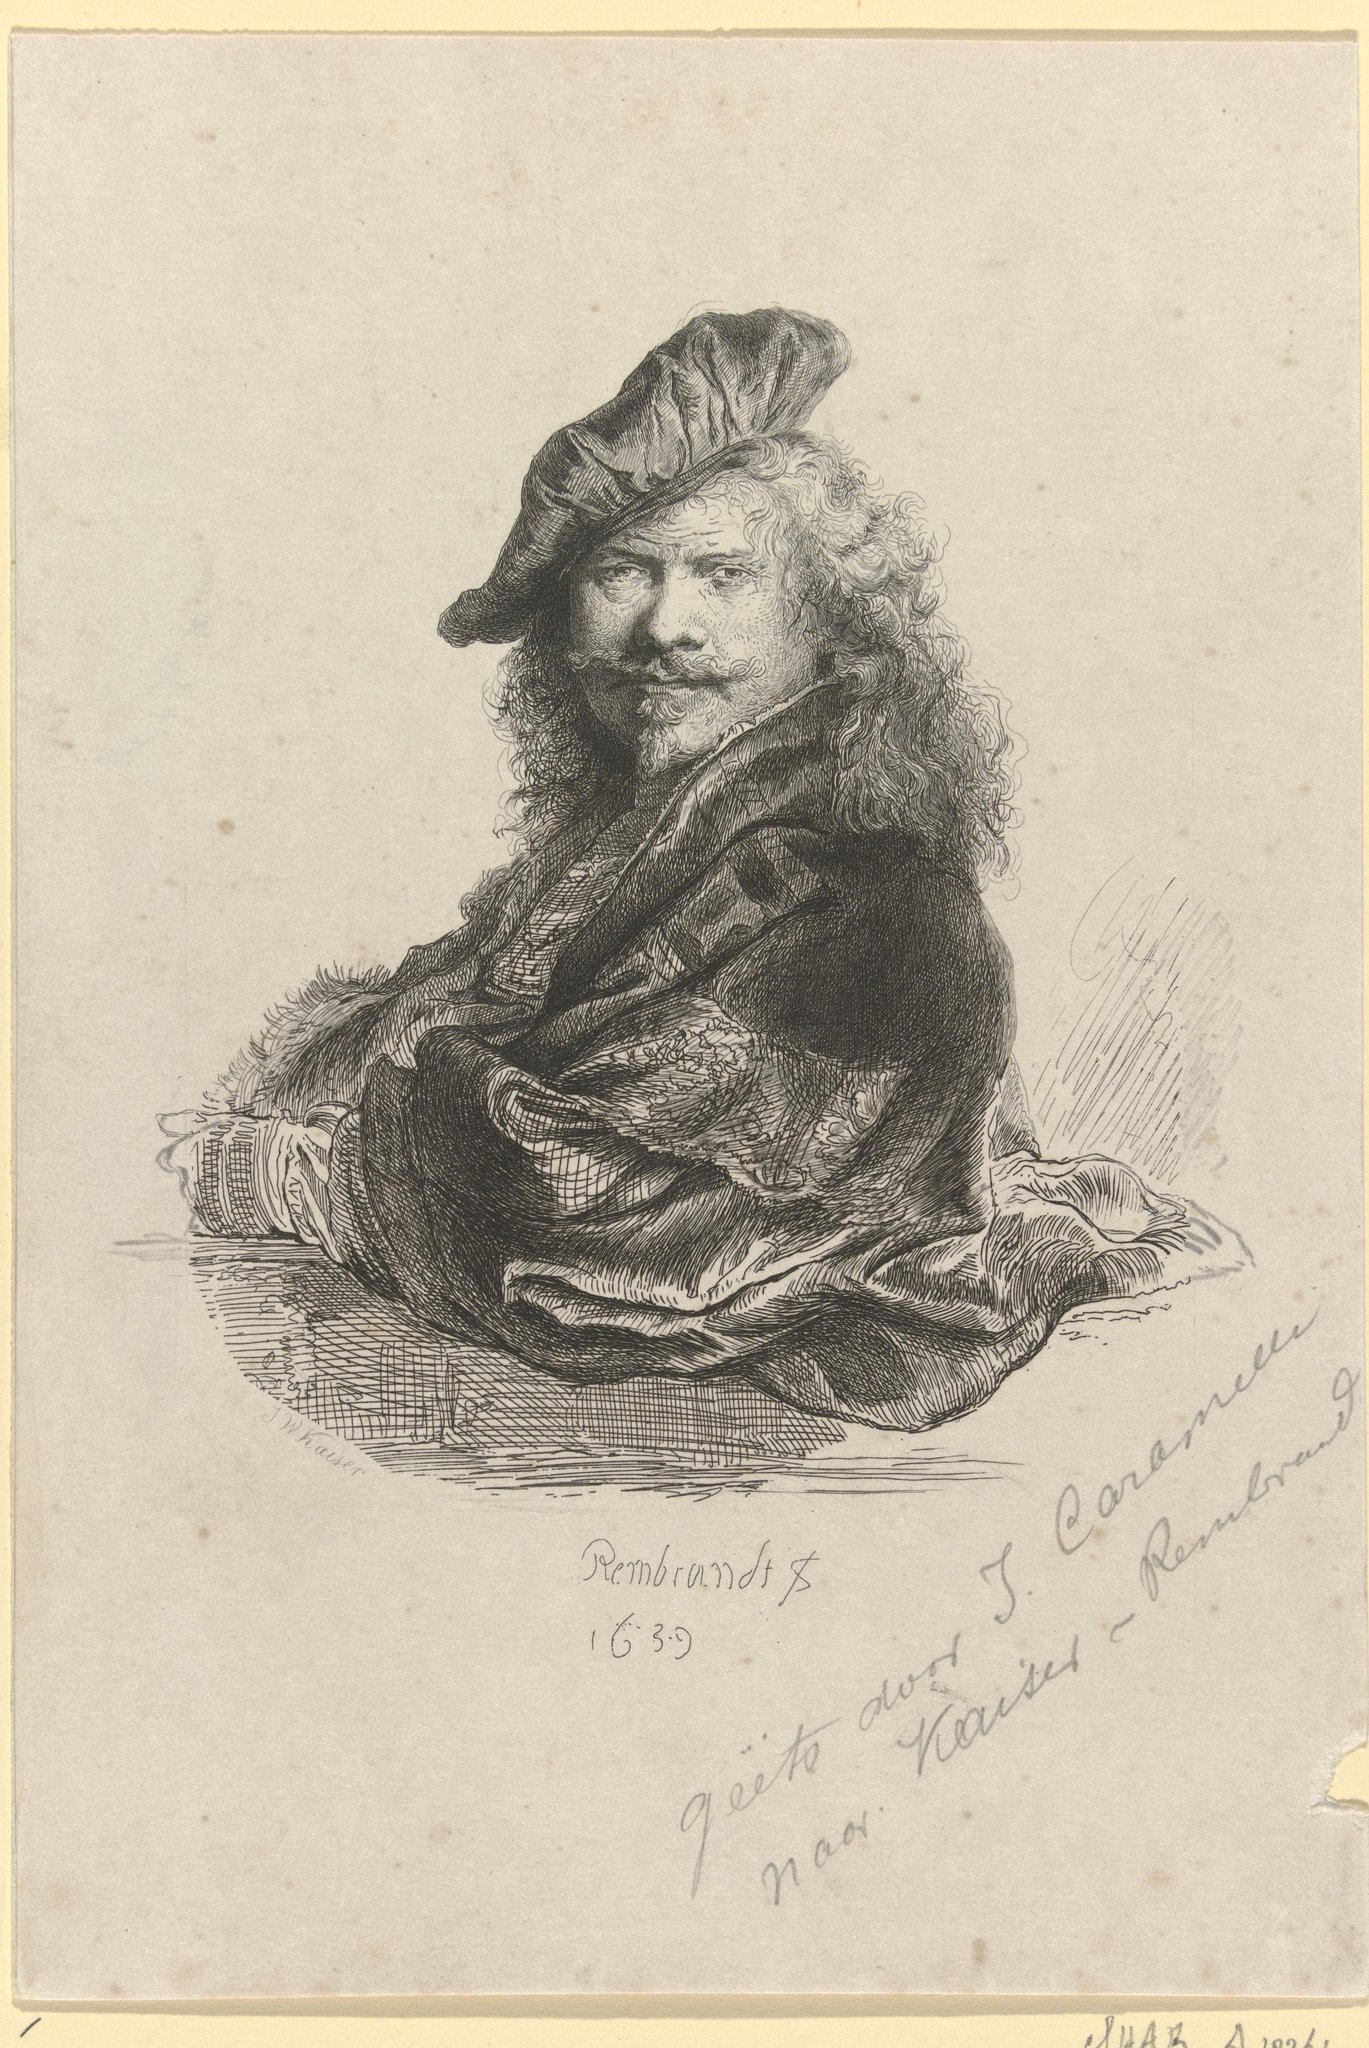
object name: print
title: Portret van Rembrandt Harmensz. van Rijn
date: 1826-1878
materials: paper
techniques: etching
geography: netherlands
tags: leiden, amsterdam, painter, print maker, draughtsman, rembrandt van rijn